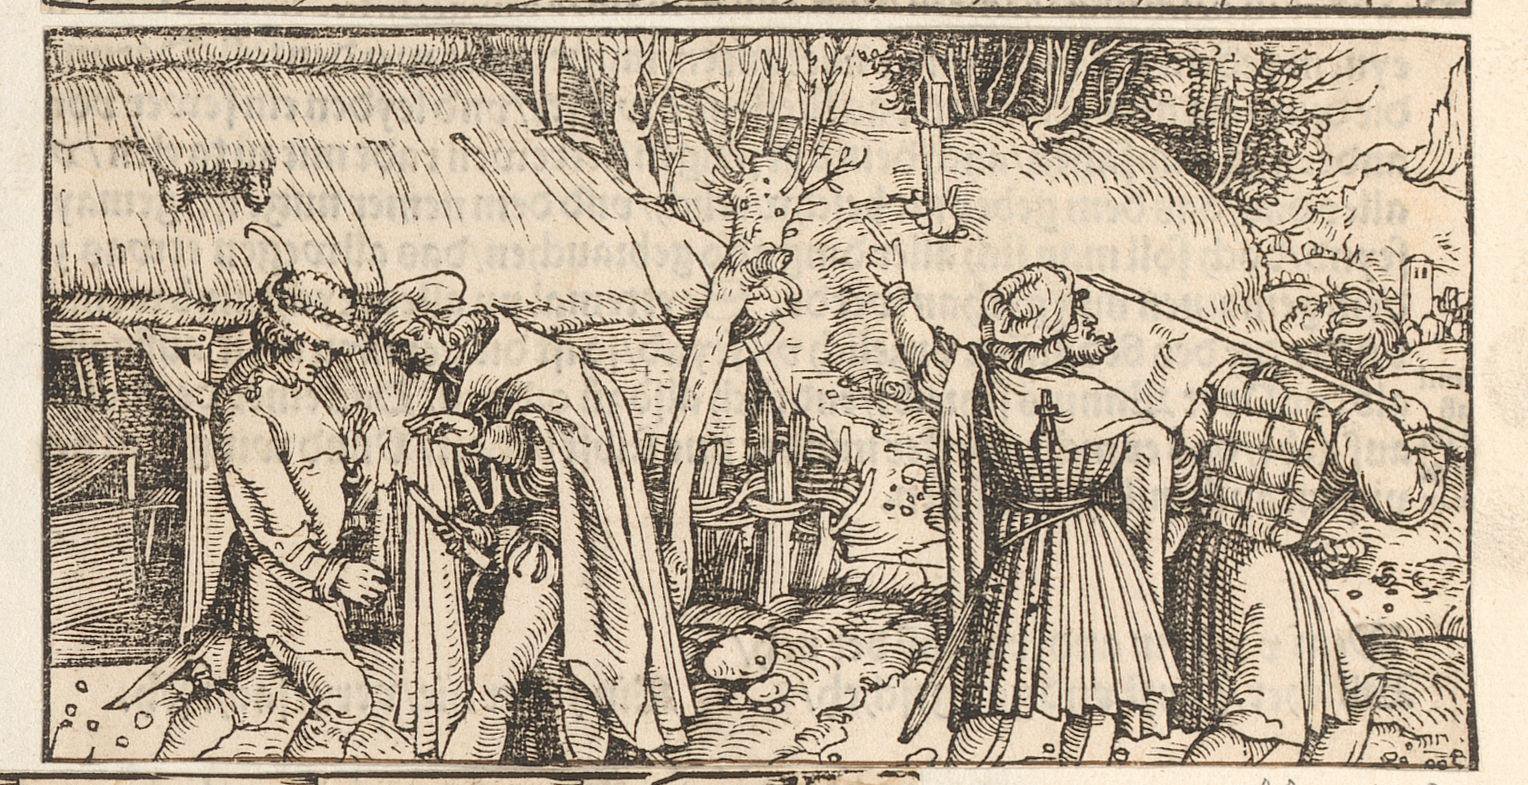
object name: book illustration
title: Twee mannen met een kaars en een andere man wijst een reiziger iets aan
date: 1514-1531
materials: paper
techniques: letterpress printing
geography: augsburg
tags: index finger forwards, pointing, indicating - aa - both arms or hands, candlestick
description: Deze prent is gebruikt in: Cicero, Marcus Tulius. Officia M.T.C. Ein Buch so Marcus Tullius Cicero der Römer zu seynem (...). [Vertaald uit het Latijn door] Johann von Schwarzenberg. Augsburg: Heinrich Steiner, 1531. Prent is mogelijk afgesneden.